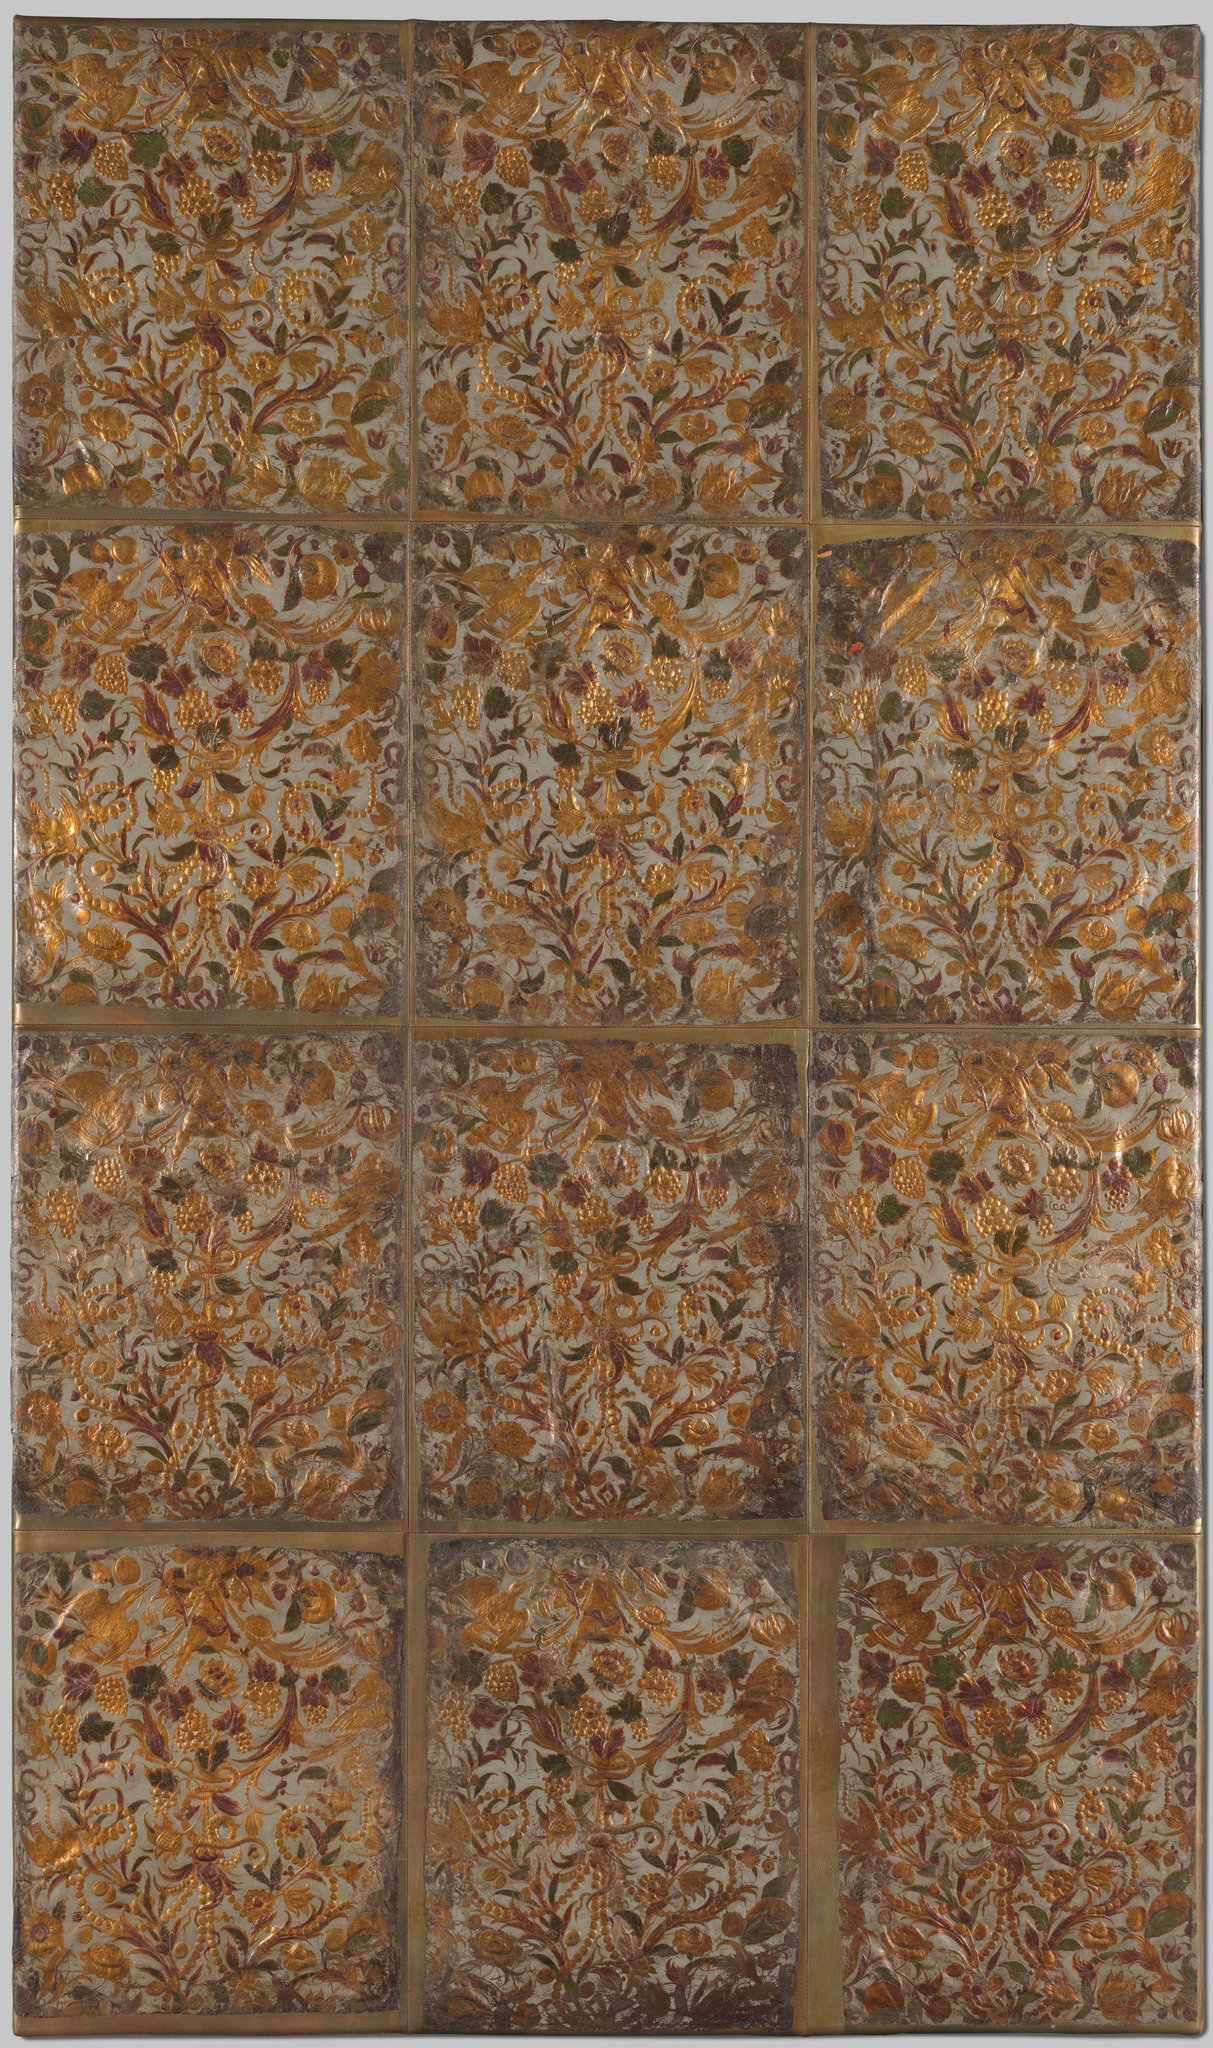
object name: interieuronderdeel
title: Paneel met twaalf vellen goudleer met op lichtgroene fond een decor van bloemen in groen, rood en goud, waartussen vogels, een putto en een hagedis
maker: Anonymous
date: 1680-1700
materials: gilt leather, leather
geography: netherlands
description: Paneel met twaalf vellen goudleer met op lichtgroene fond een decor van bloemen in groen, rood en goud, waartussen vogels, een putto en een hagedis.